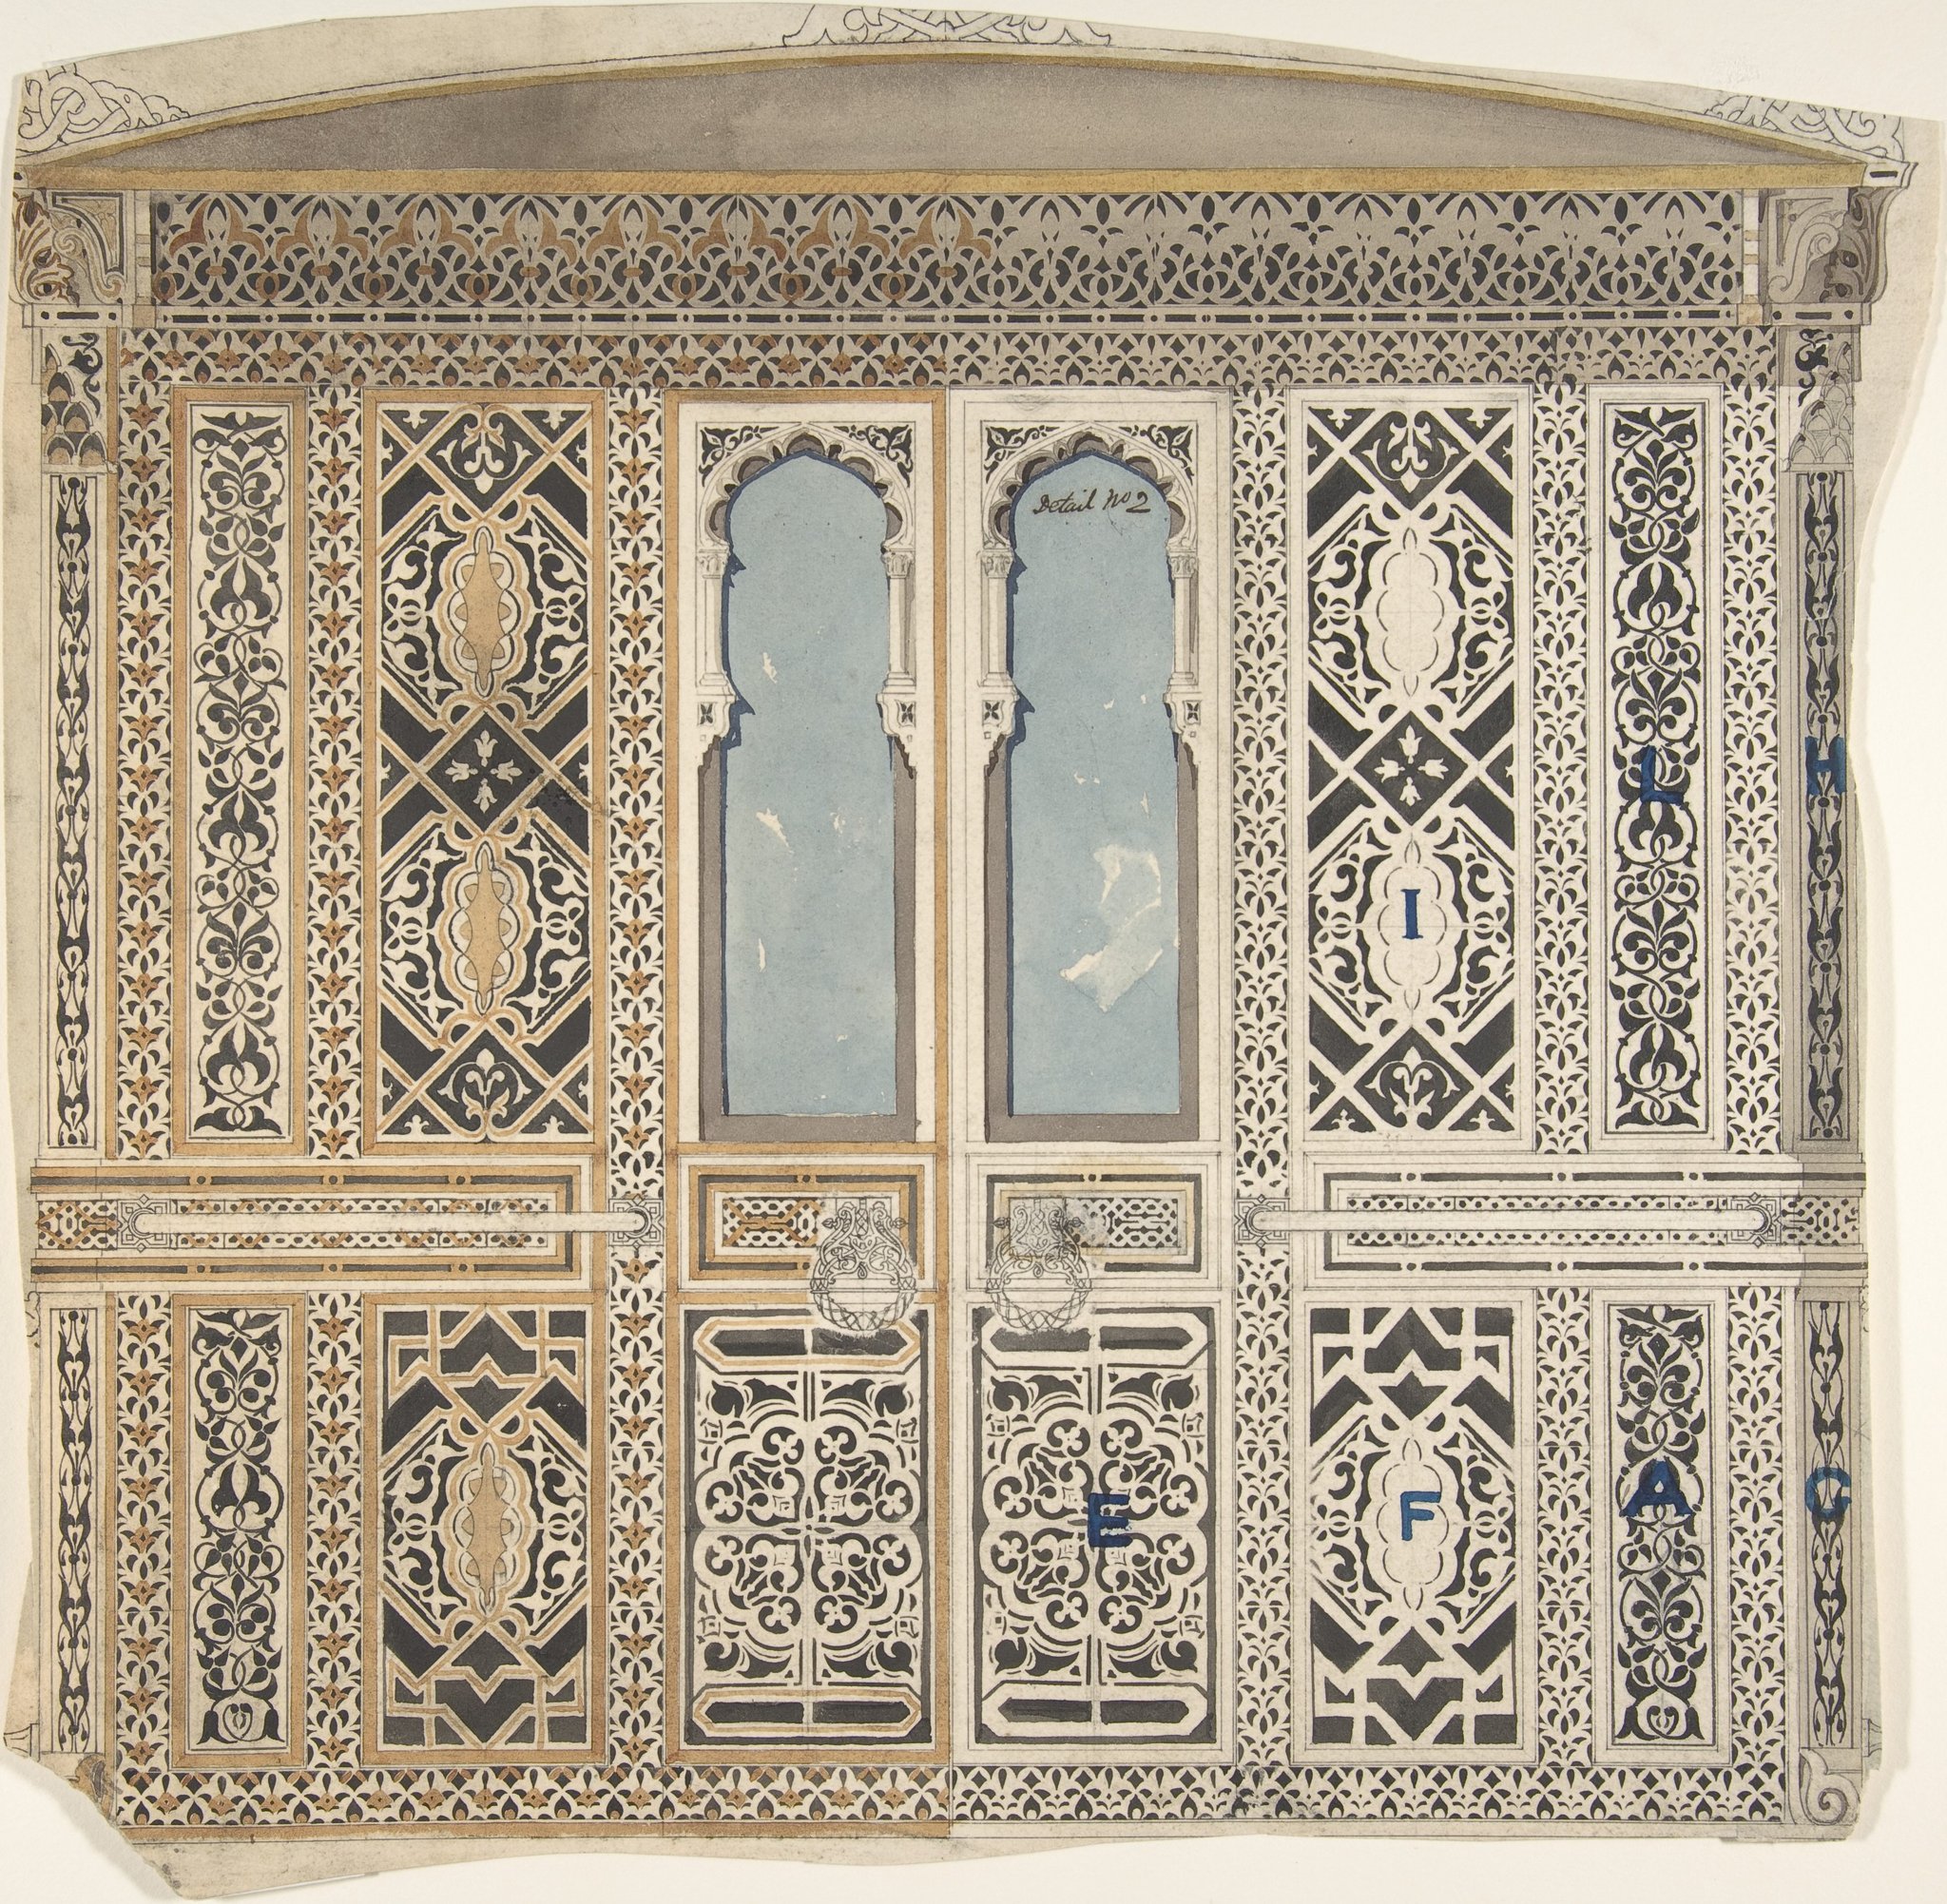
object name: drawing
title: Moorish Wall Elevation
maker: anonymous, british, 19th century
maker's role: artist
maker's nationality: british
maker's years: 1800-1900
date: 1801-1900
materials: ink, watercolor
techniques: brush, pen, wash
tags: architecture,ornament